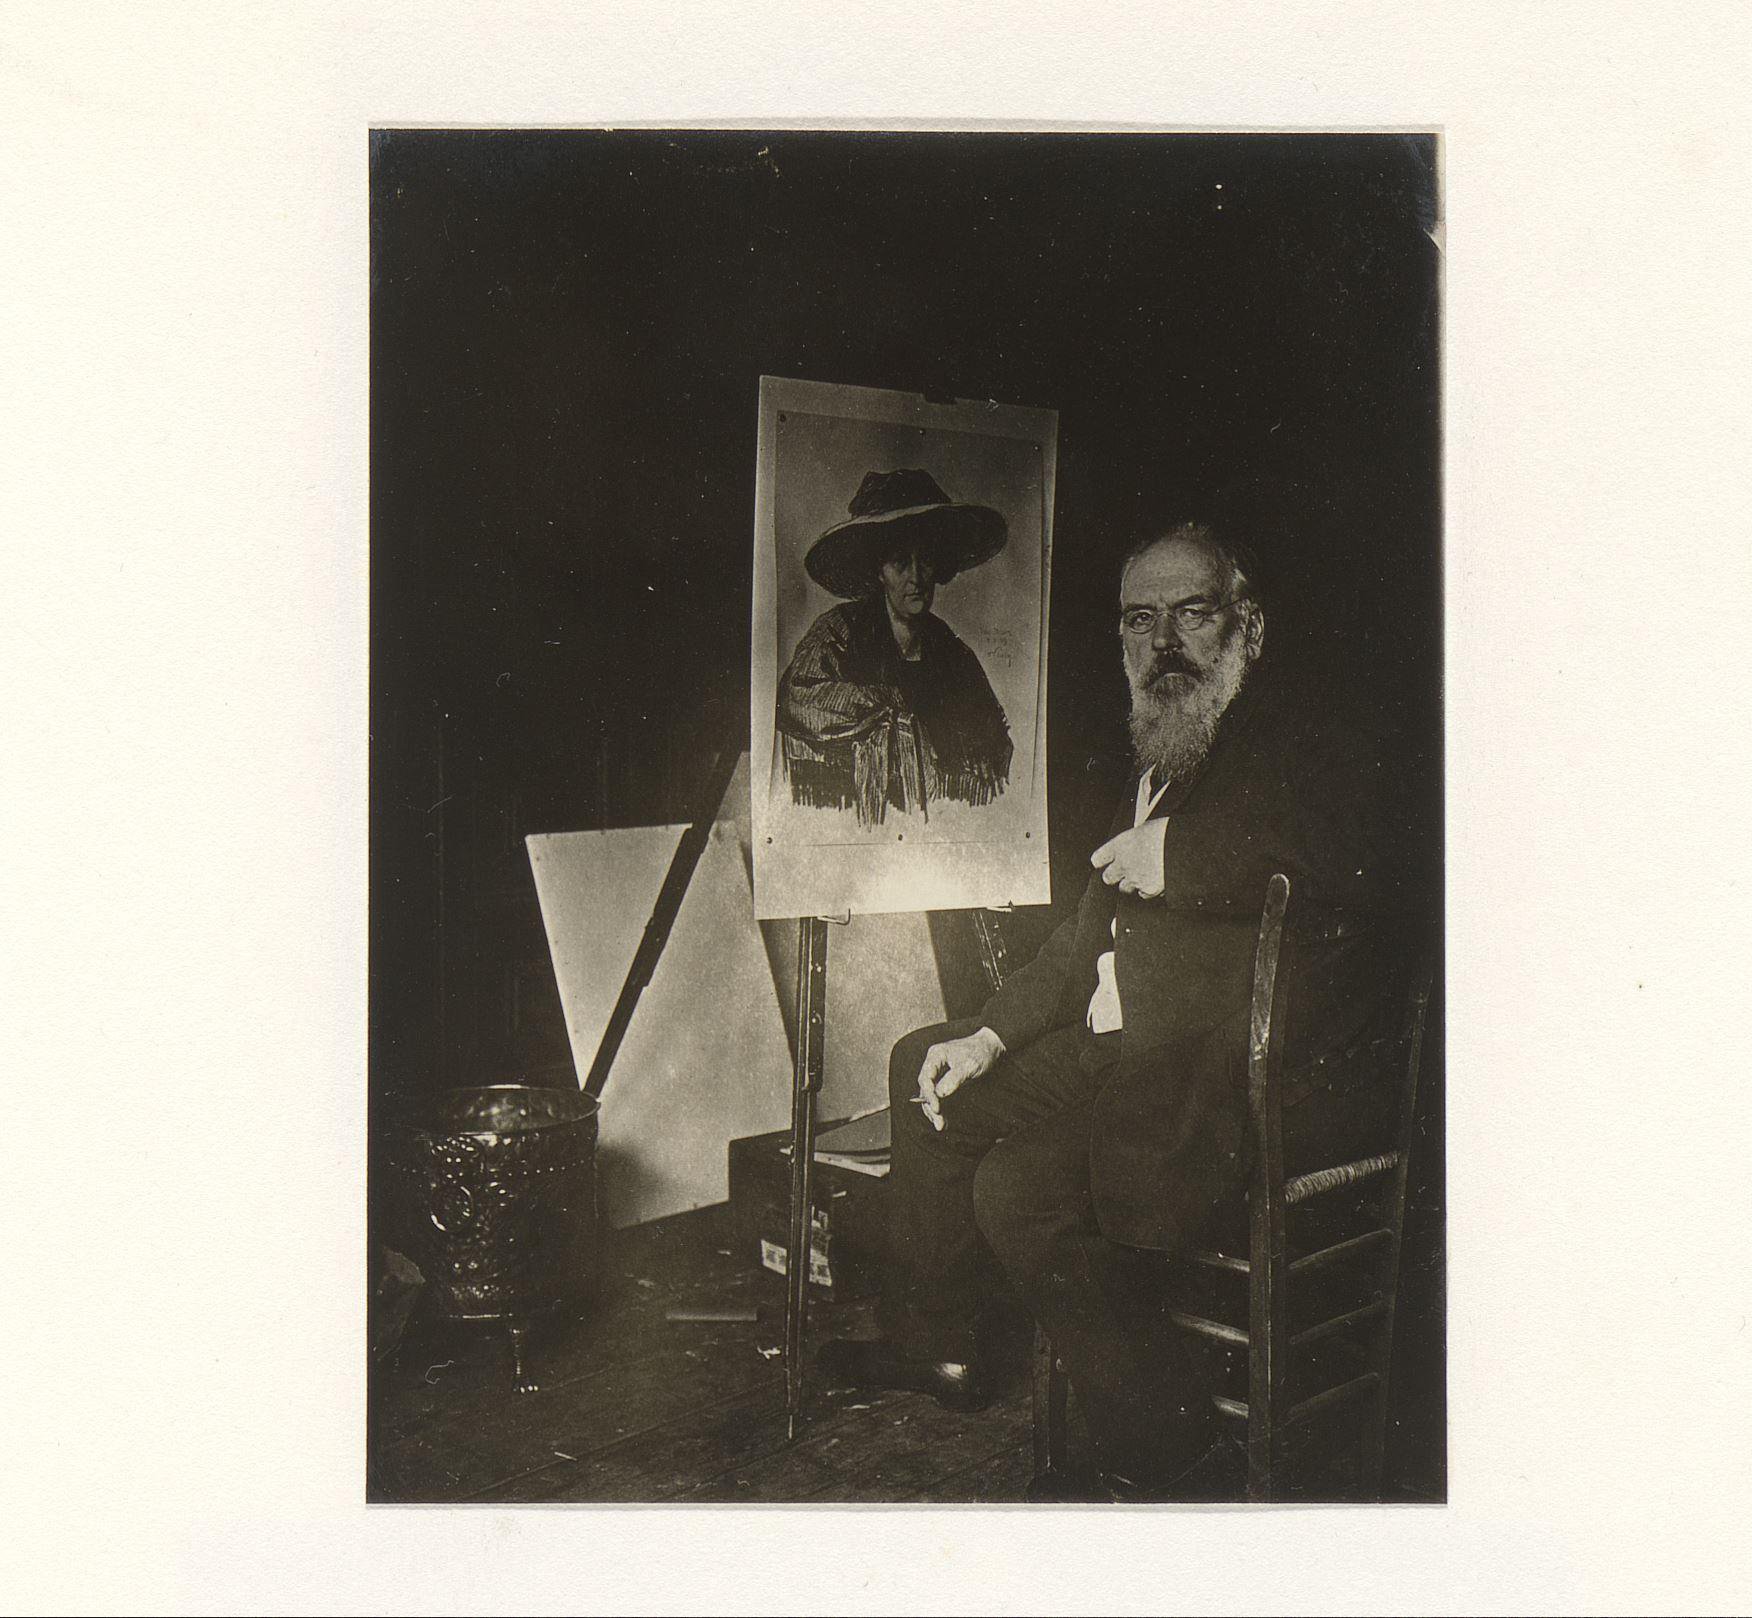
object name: photograph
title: Man in een schildersatelier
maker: george hidderley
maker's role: fotograaf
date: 1900-1910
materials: paper, photographic support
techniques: gelatin silver print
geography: volendam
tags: adult man, historical persons, workshop, studio ~ painter